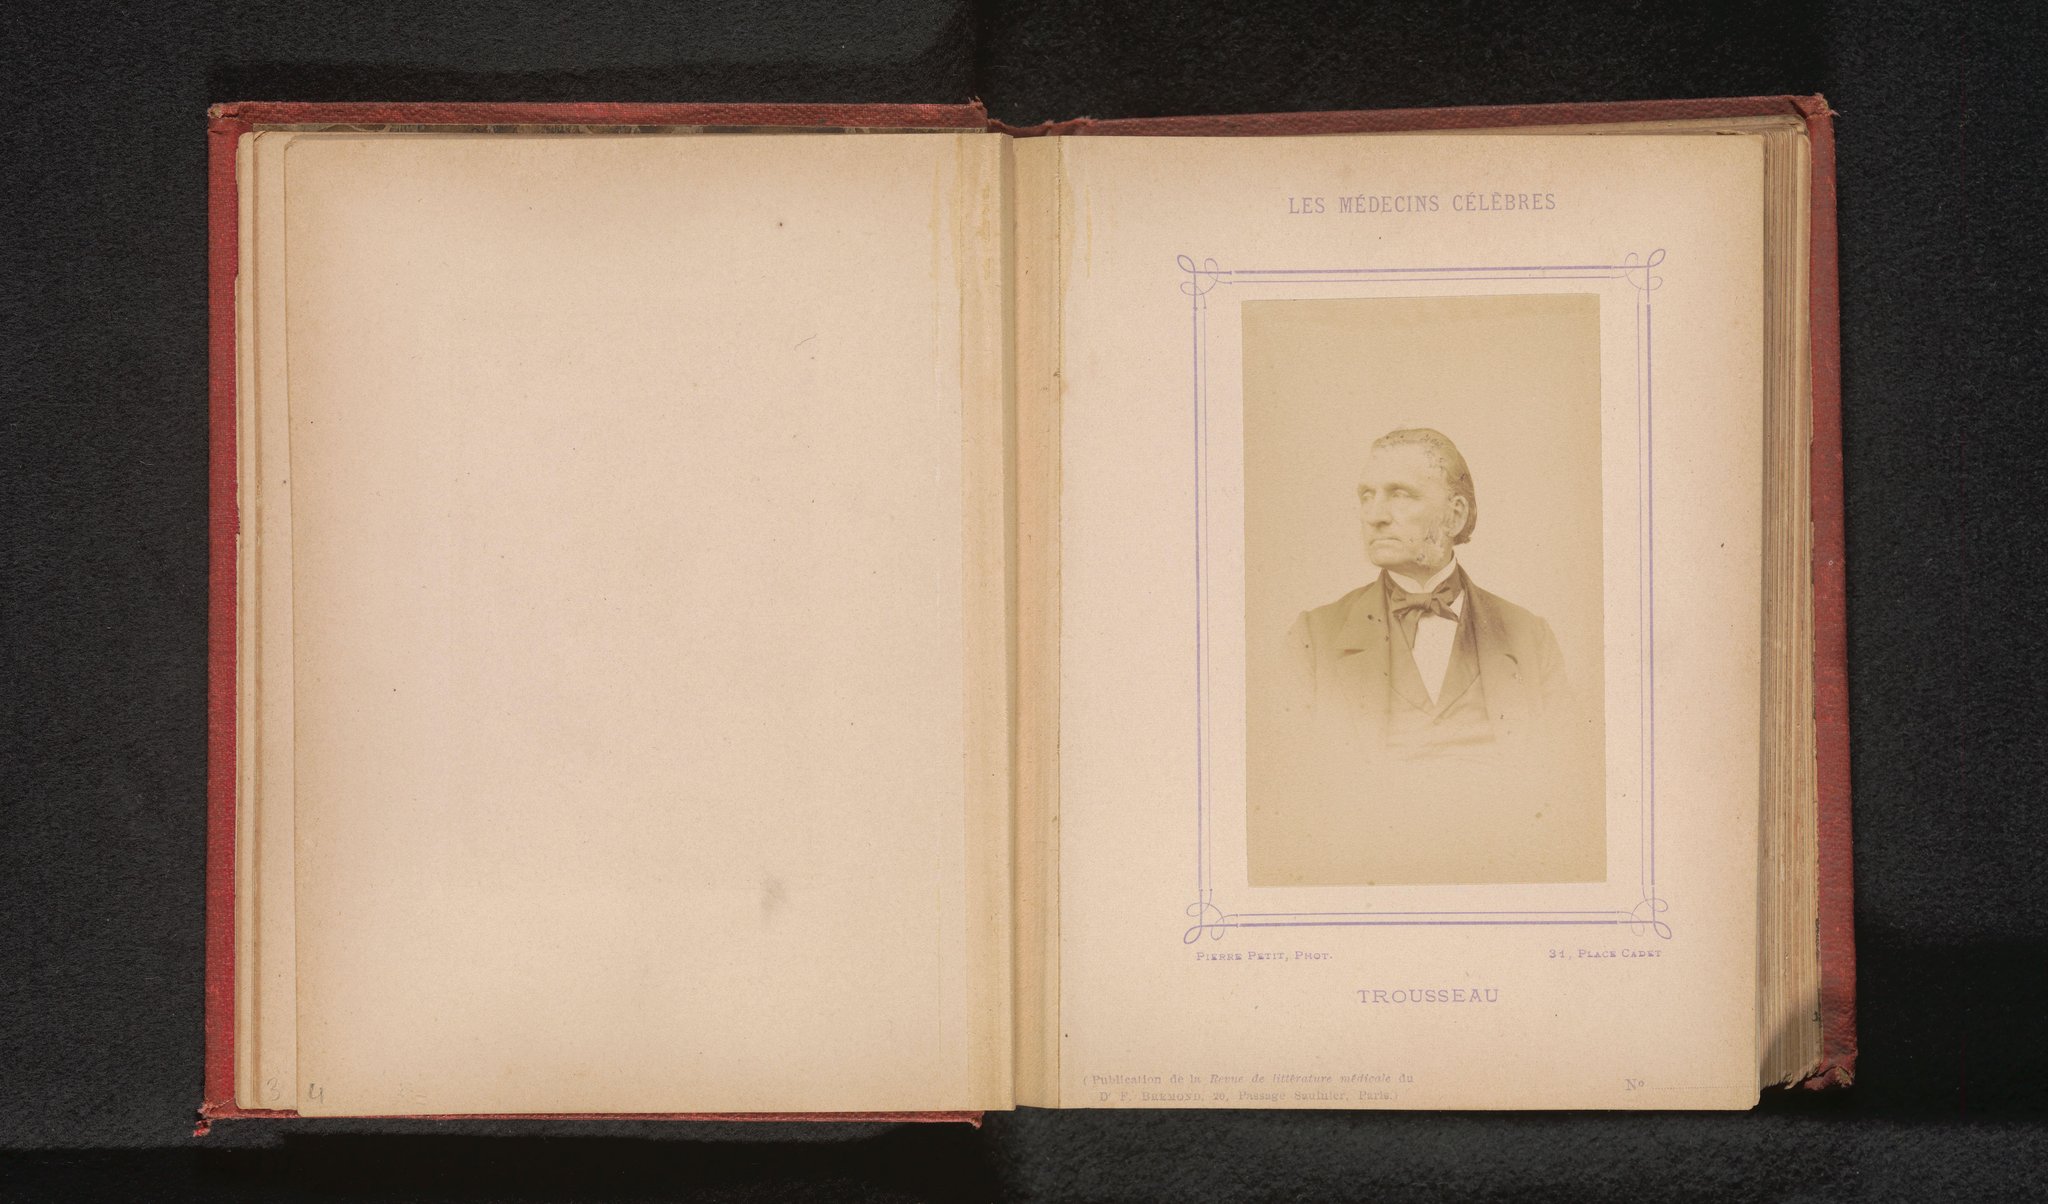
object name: photograph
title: Trousseau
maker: pierre petit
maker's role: fotograaf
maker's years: 1832-1909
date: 1871-1879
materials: paper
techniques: albumen print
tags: adult man, historical persons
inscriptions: inscription: ‘(Publication de la Revue de litterature médicale du/ D. F. Bremond, 5 Rue Beudant, Paris. No.]’